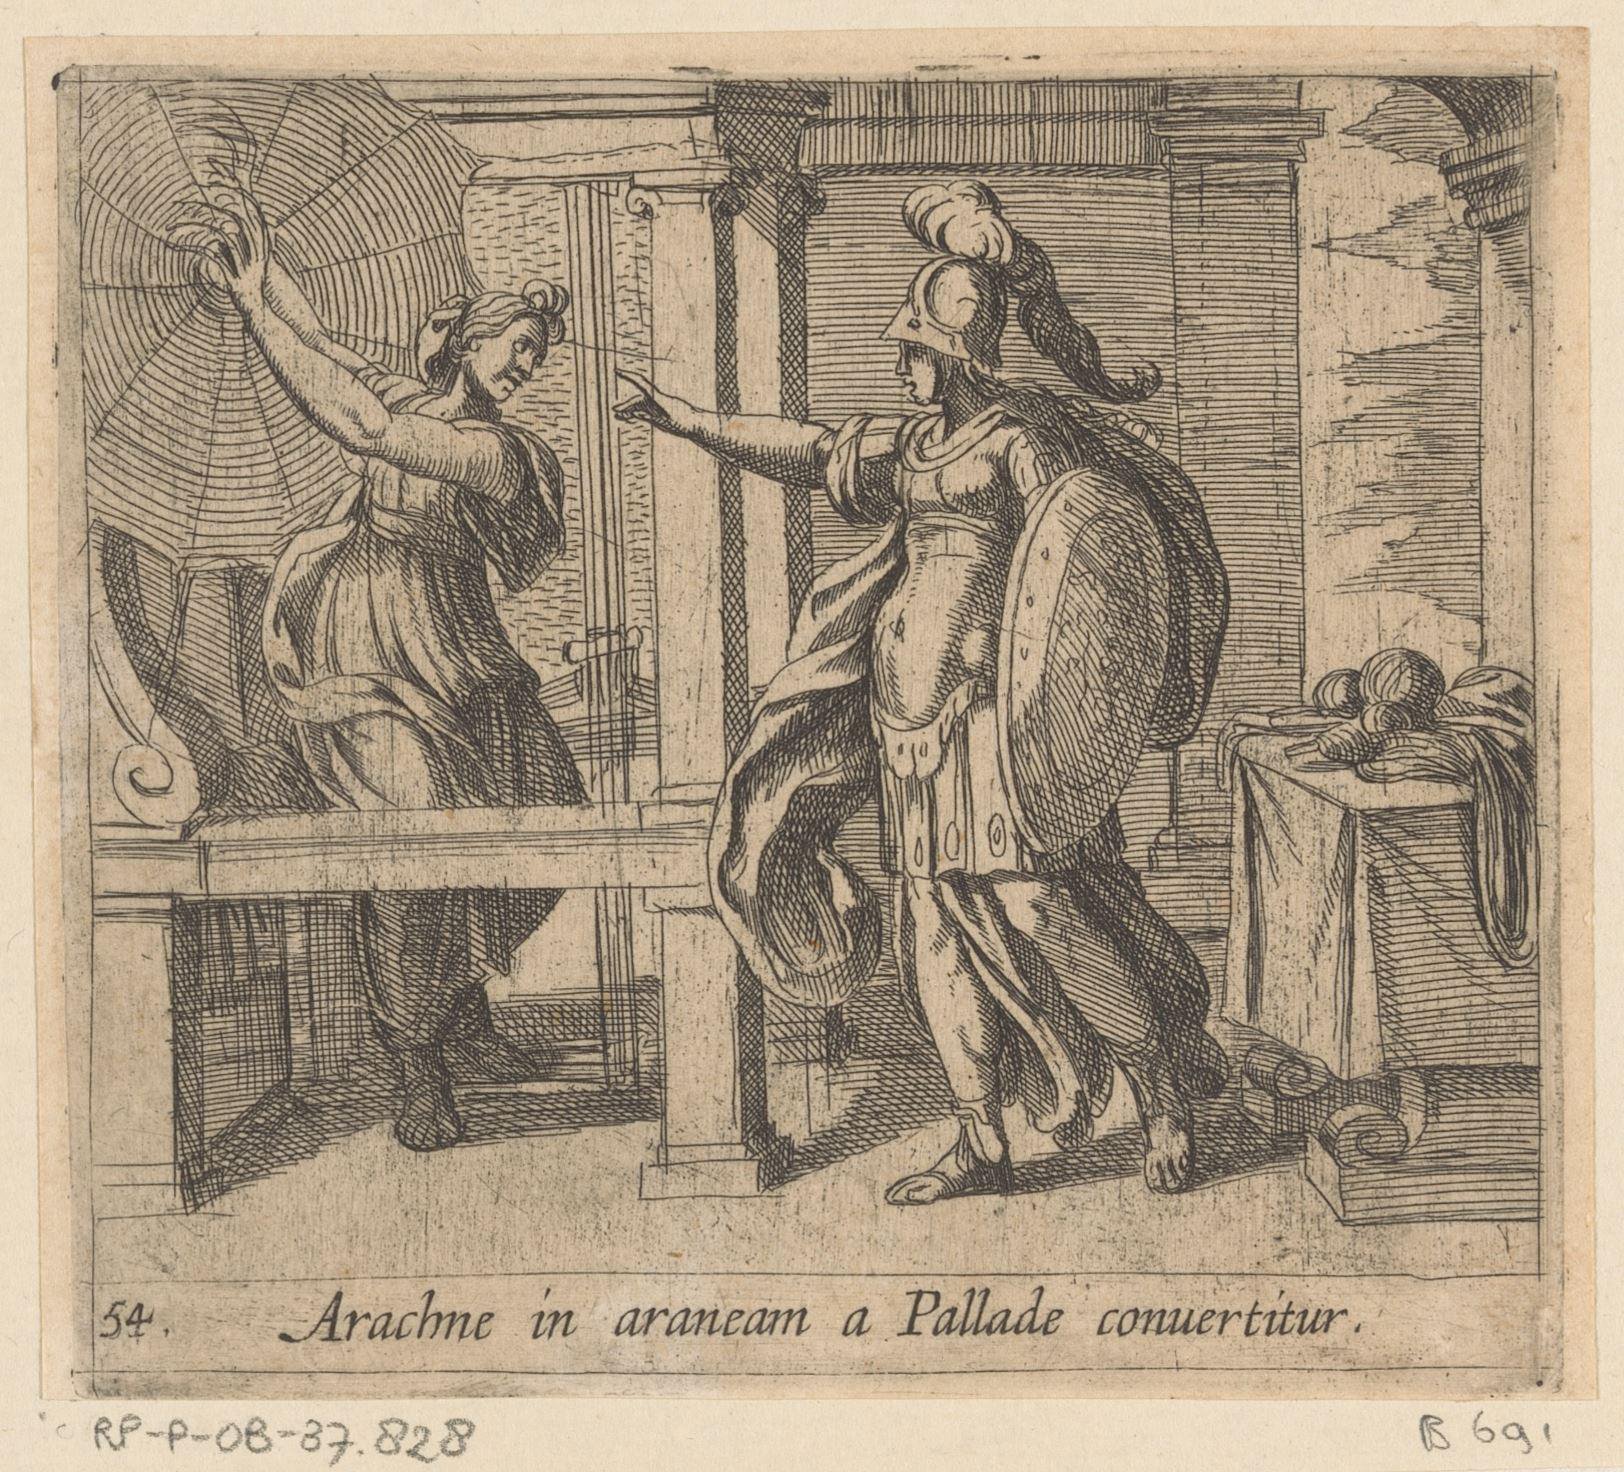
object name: print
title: Metamorphoseon sive transformationum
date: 1606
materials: paper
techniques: etching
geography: antwerp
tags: arachne changed into a spider: when hanging herself after having been defeated in a weaving contest with minerva, arachne is changed into a spider by the goddess (ovid, metamorphoses vi 135), spiders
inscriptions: collector's mark: Lugt 240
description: Deze prent maakt deel uit van een reeks van 150 prenten (+ titelprent) met voorstellingen van de Metamorfosen van Ovidius.